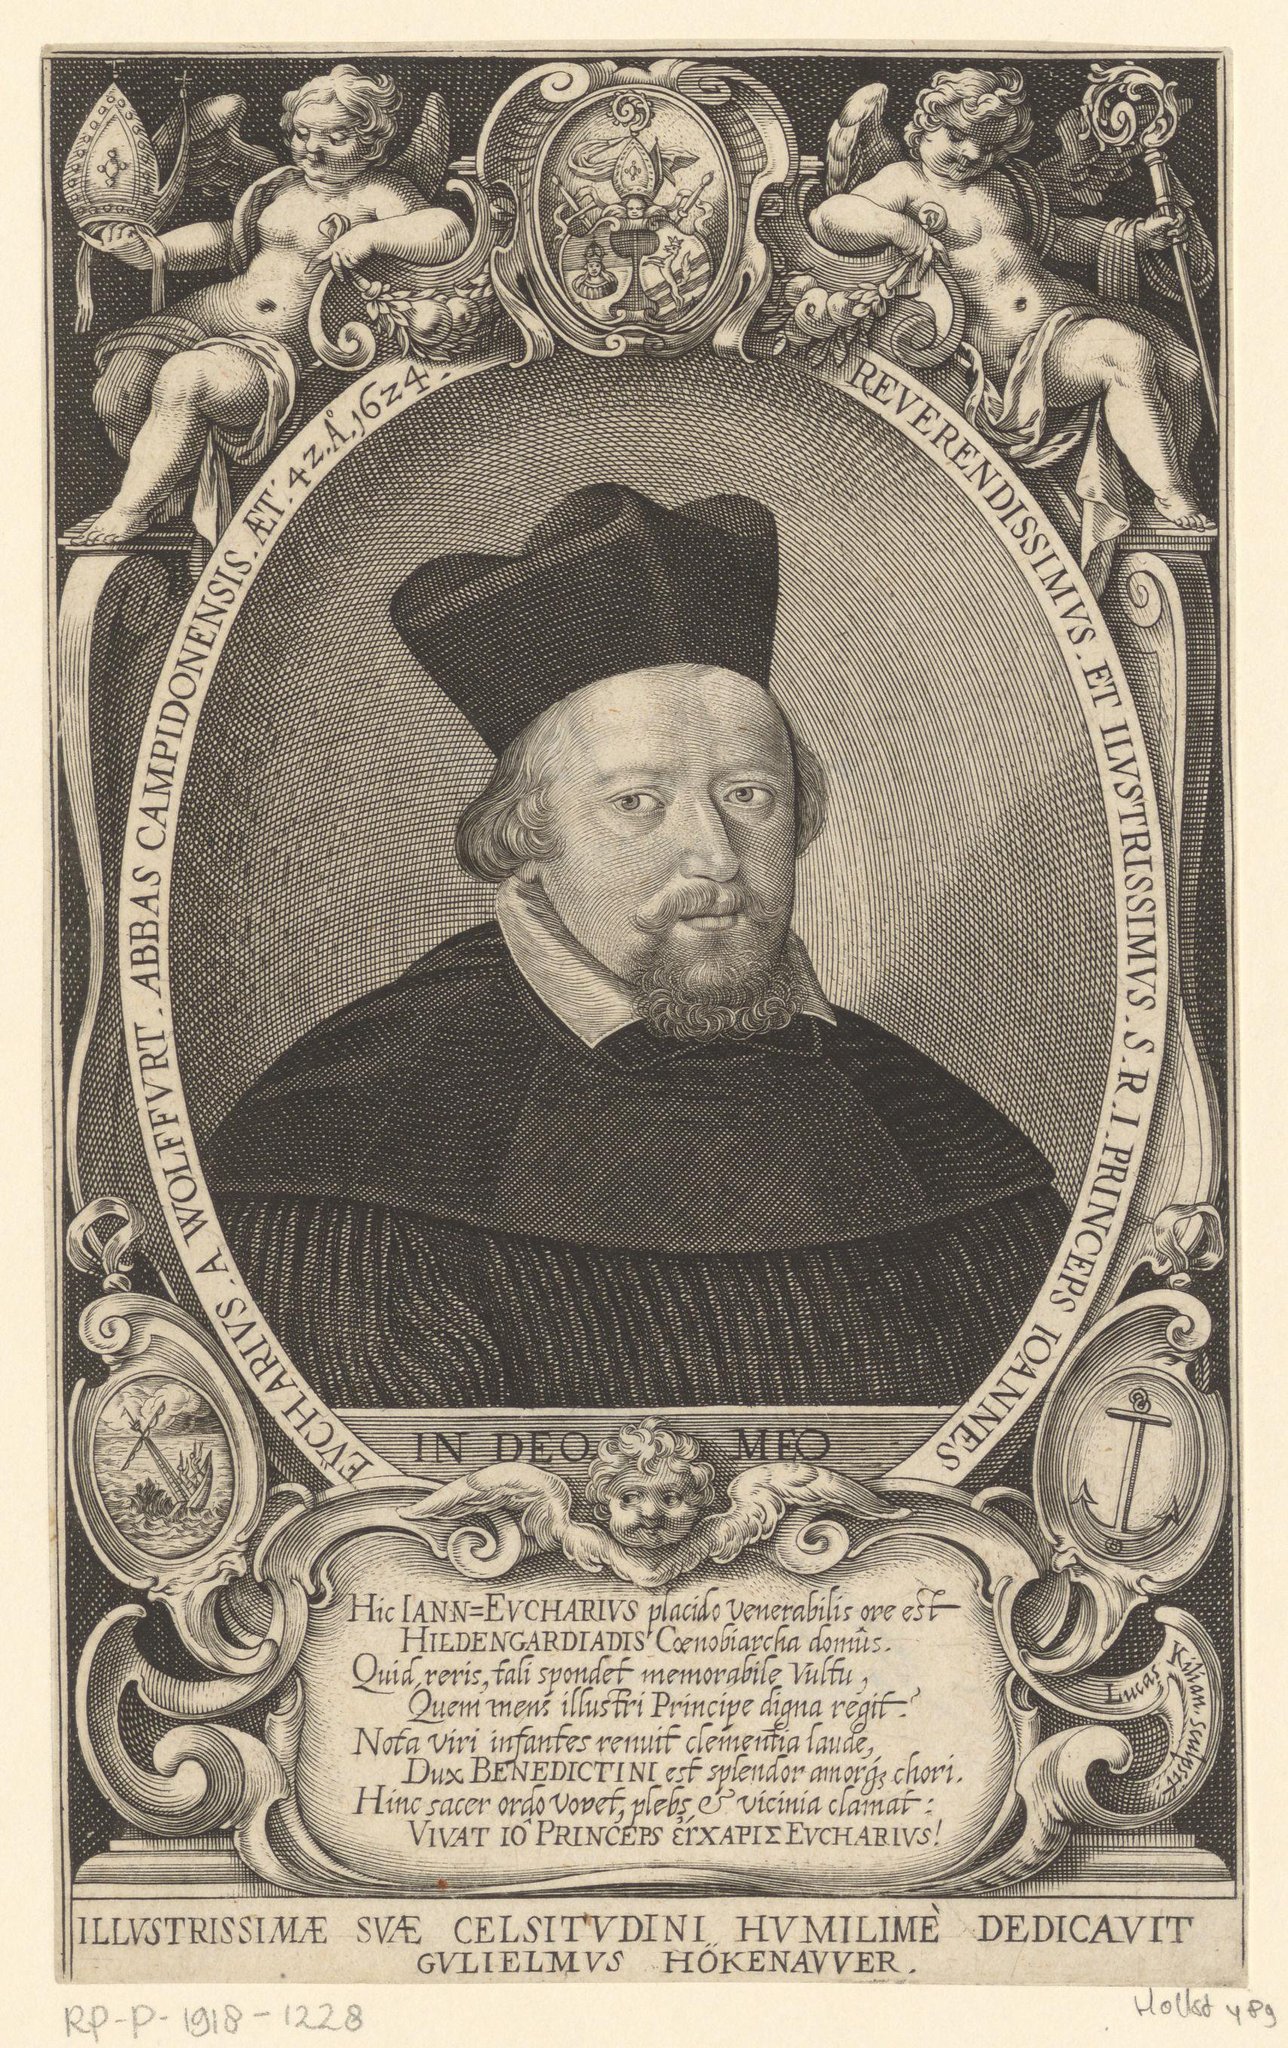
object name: print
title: Portret van Johann Eucharius von Wolffurt op 42-jarige leeftijd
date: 1624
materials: paper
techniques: engraving, etching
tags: historical persons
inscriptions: dedication: ‘(...) Dedicavit Gulielmus Hökenauer’, collector's mark: Lugt 2233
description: Putti houden een mijter en staf vast, onderaan een zinkend schip en een anker. Tekst in het Latijn in de omlijsting en in de cartouche.